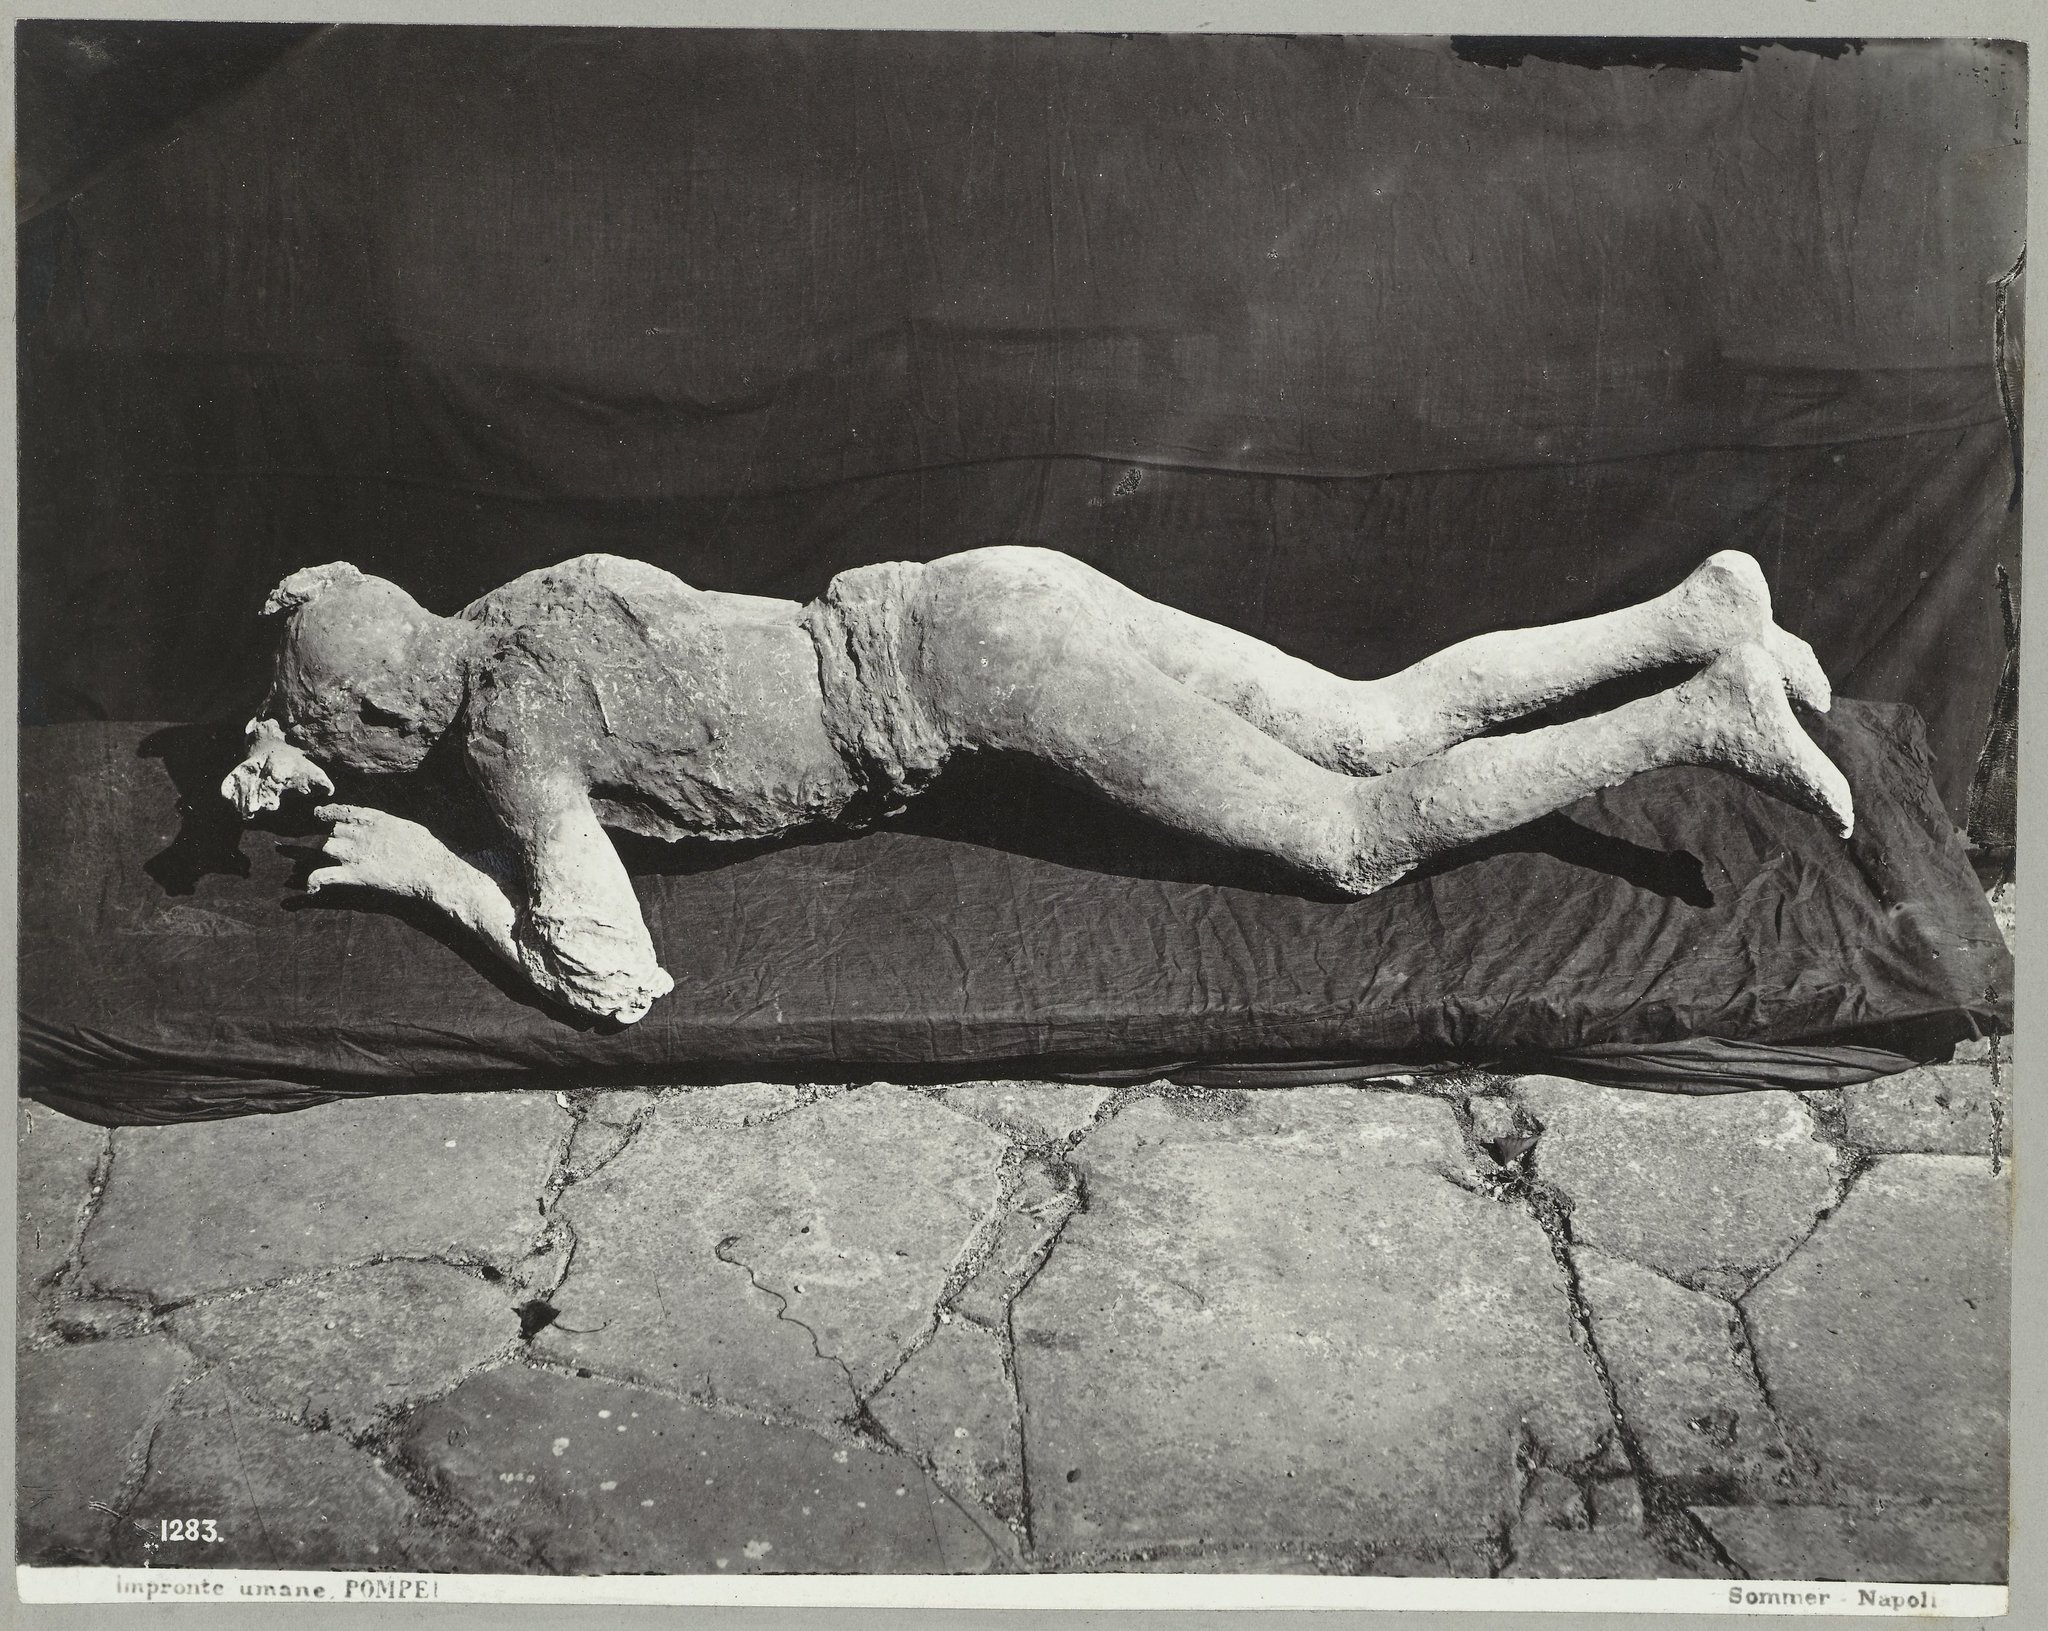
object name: photograph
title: 1283 Impronte umane Pompei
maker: giorgio sommer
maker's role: fotograaf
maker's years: 1834-1914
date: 1888-1903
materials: cardboard, photographic support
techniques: albumen print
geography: naples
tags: pompeii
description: Een versteend lijk van een mens gevonden te Pompeï.